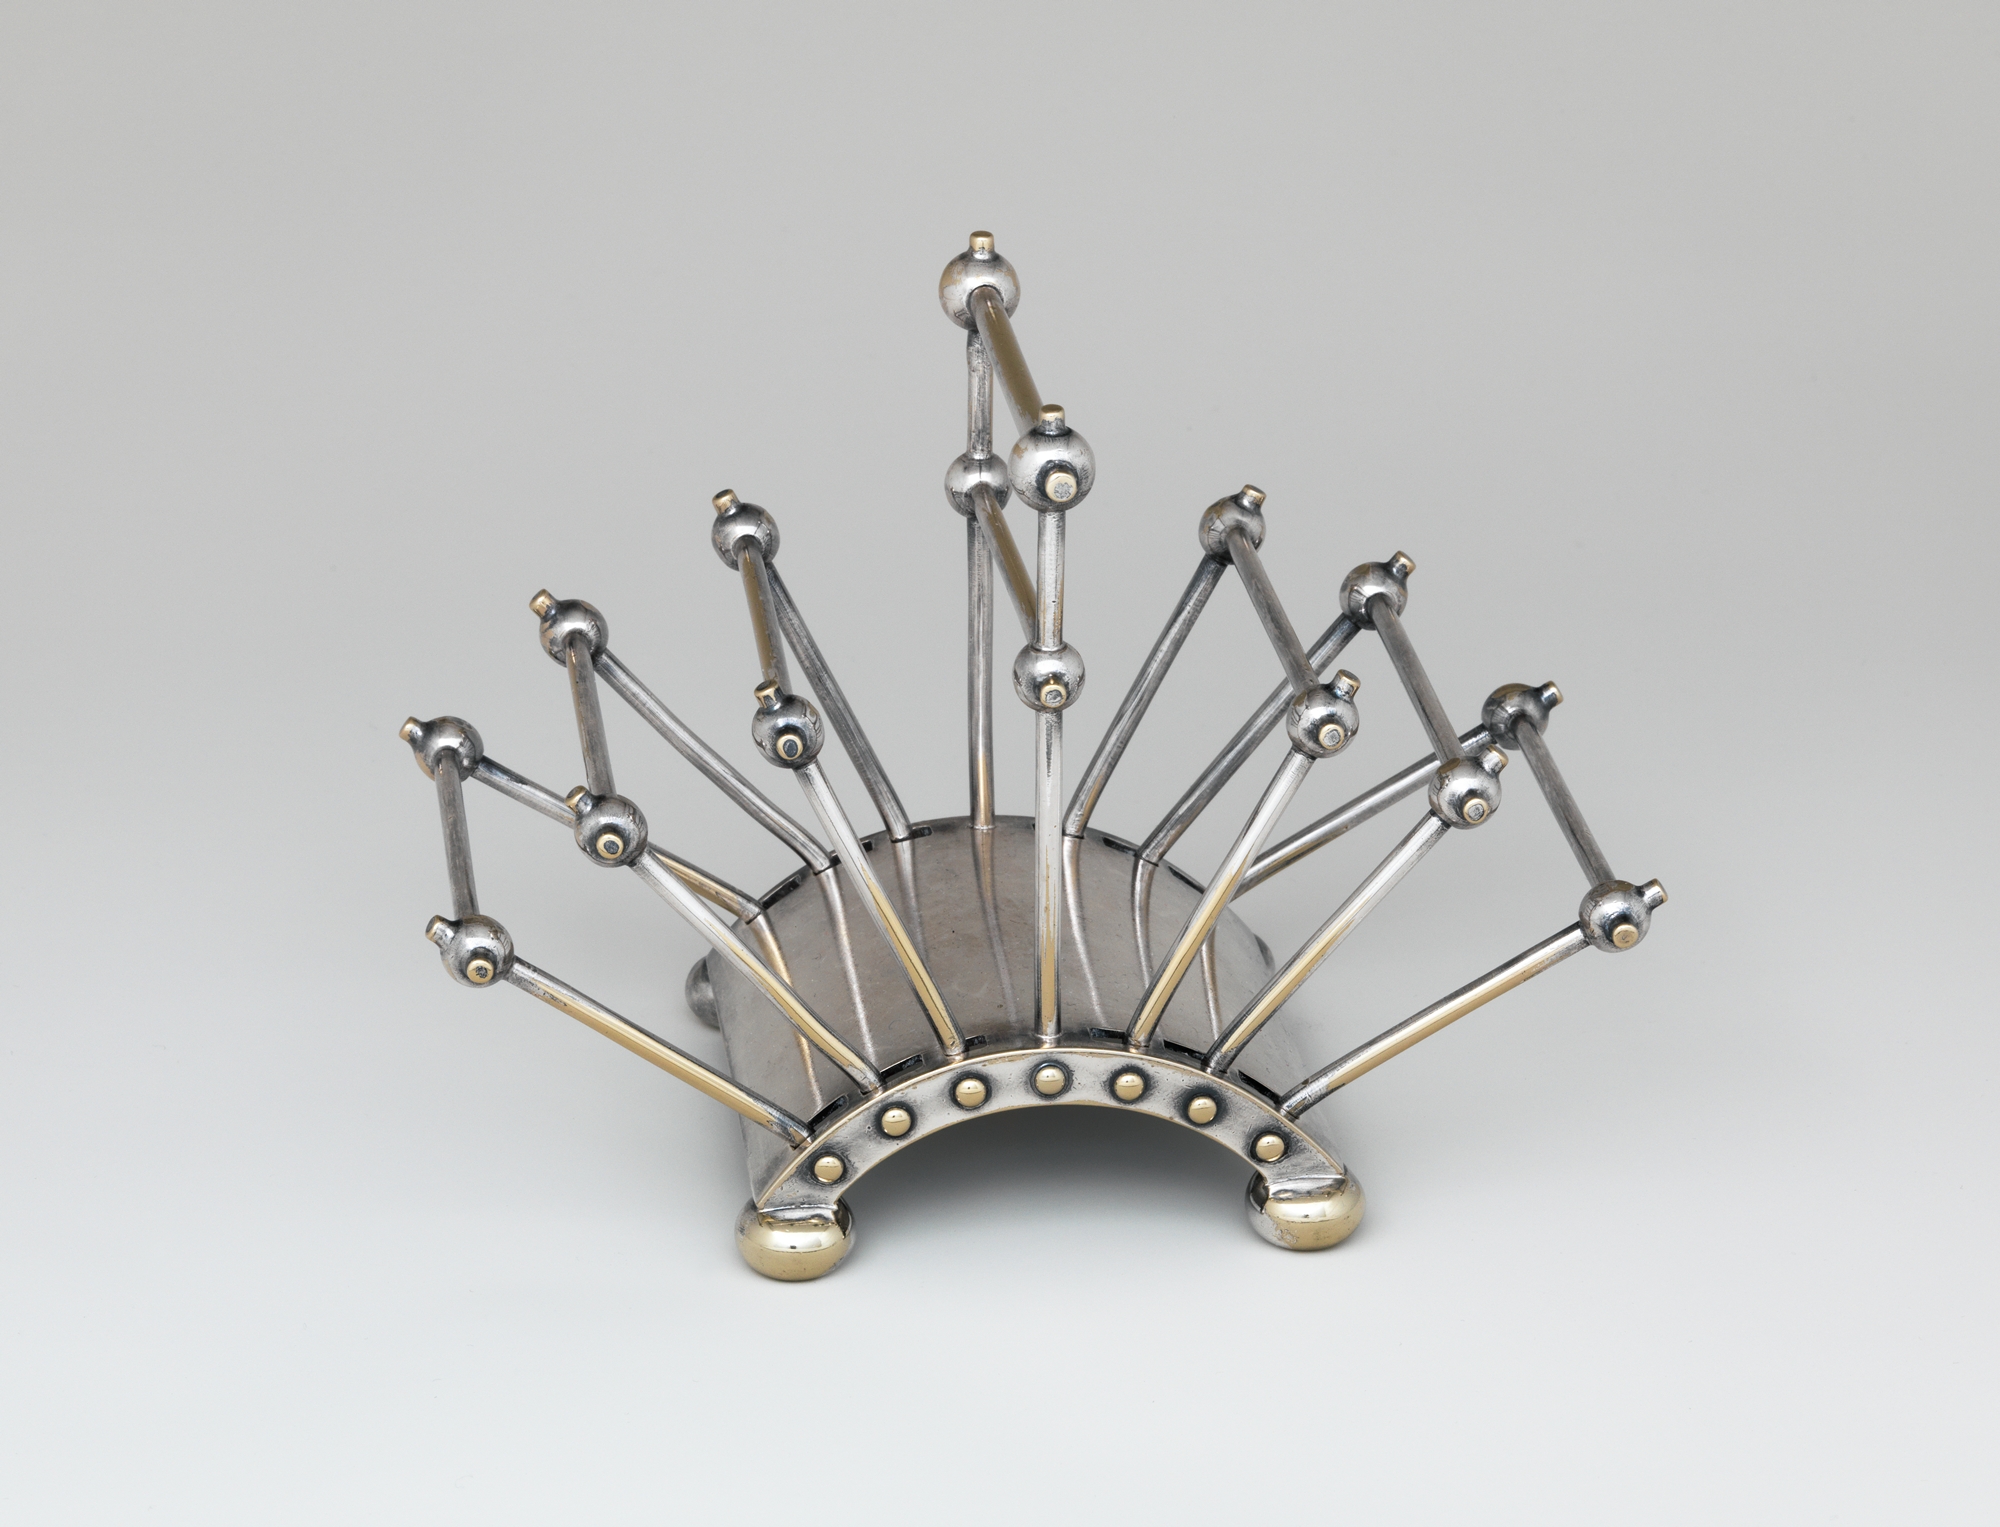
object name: toast rack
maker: christopher dresser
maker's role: designer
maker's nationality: british, scottish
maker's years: 1834-1904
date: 1881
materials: silver